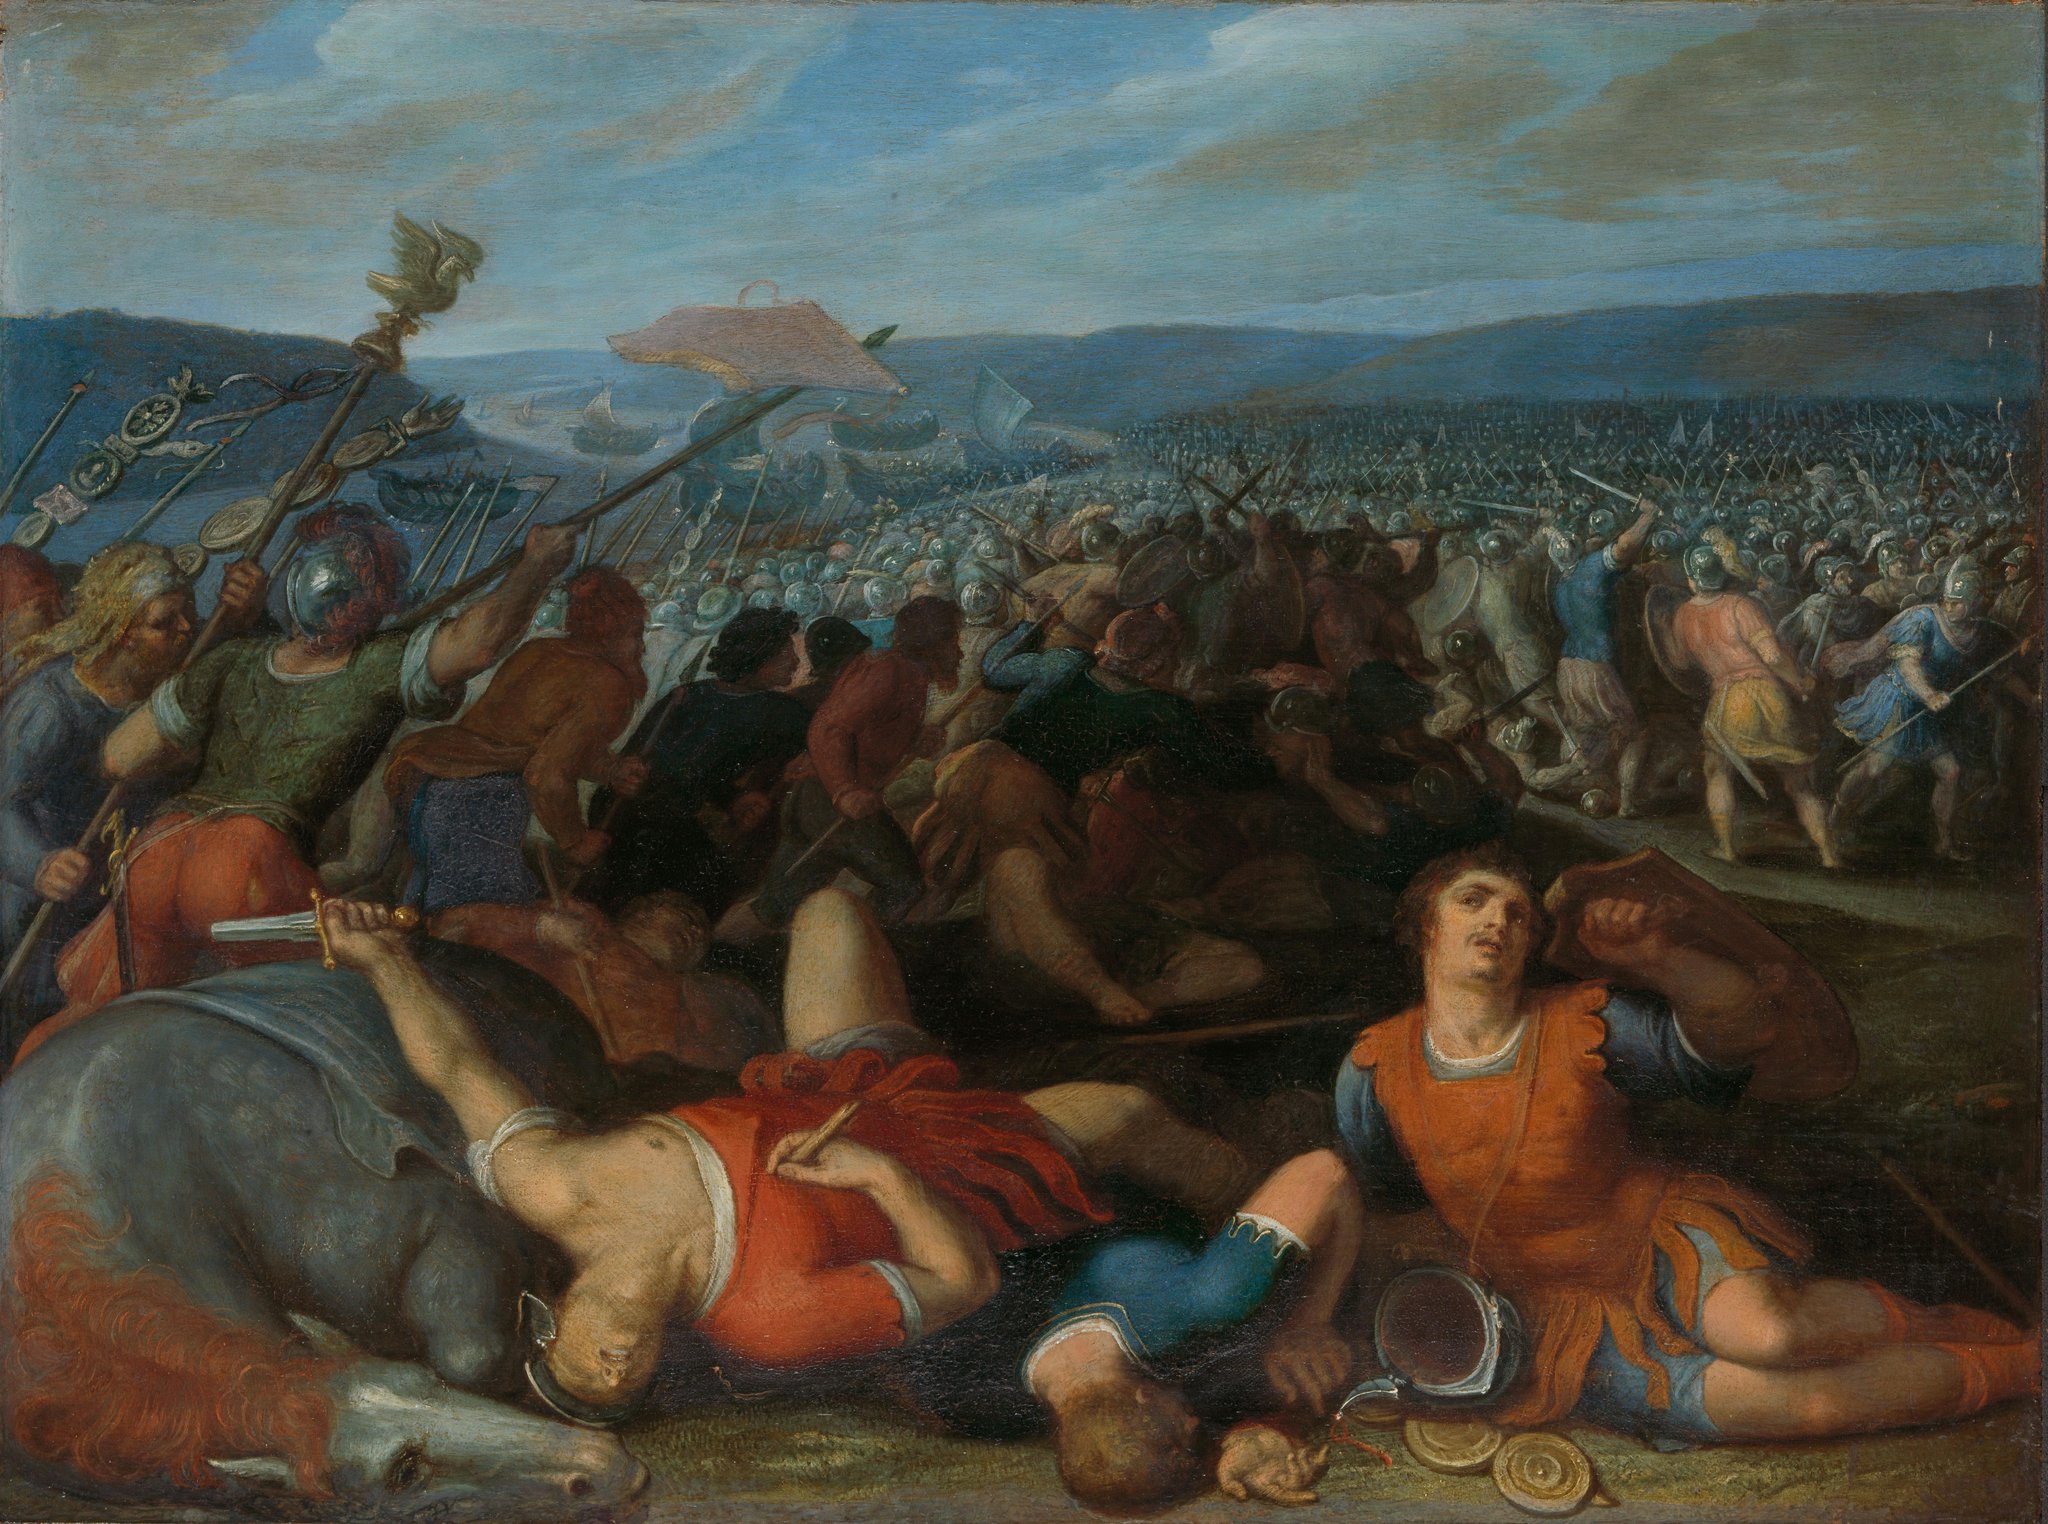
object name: painting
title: The Batavians Defeating the Romans on the Rhine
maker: otto van veen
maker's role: draughtsman, painter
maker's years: 1556-1629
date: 1600-1613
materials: oil, panel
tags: river, battle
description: In 1613, the Dutch parliament (States General) commissioned Otto van Veen to paint twelve paintings depicting the revolt of the Batavians against the Romans in AD 69 and 70. These were displayed in Binnenhof, the central government building in The Hague. In the early years of the Dutch Republic, many compared their own revolt against Spain to the Batavian uprising.